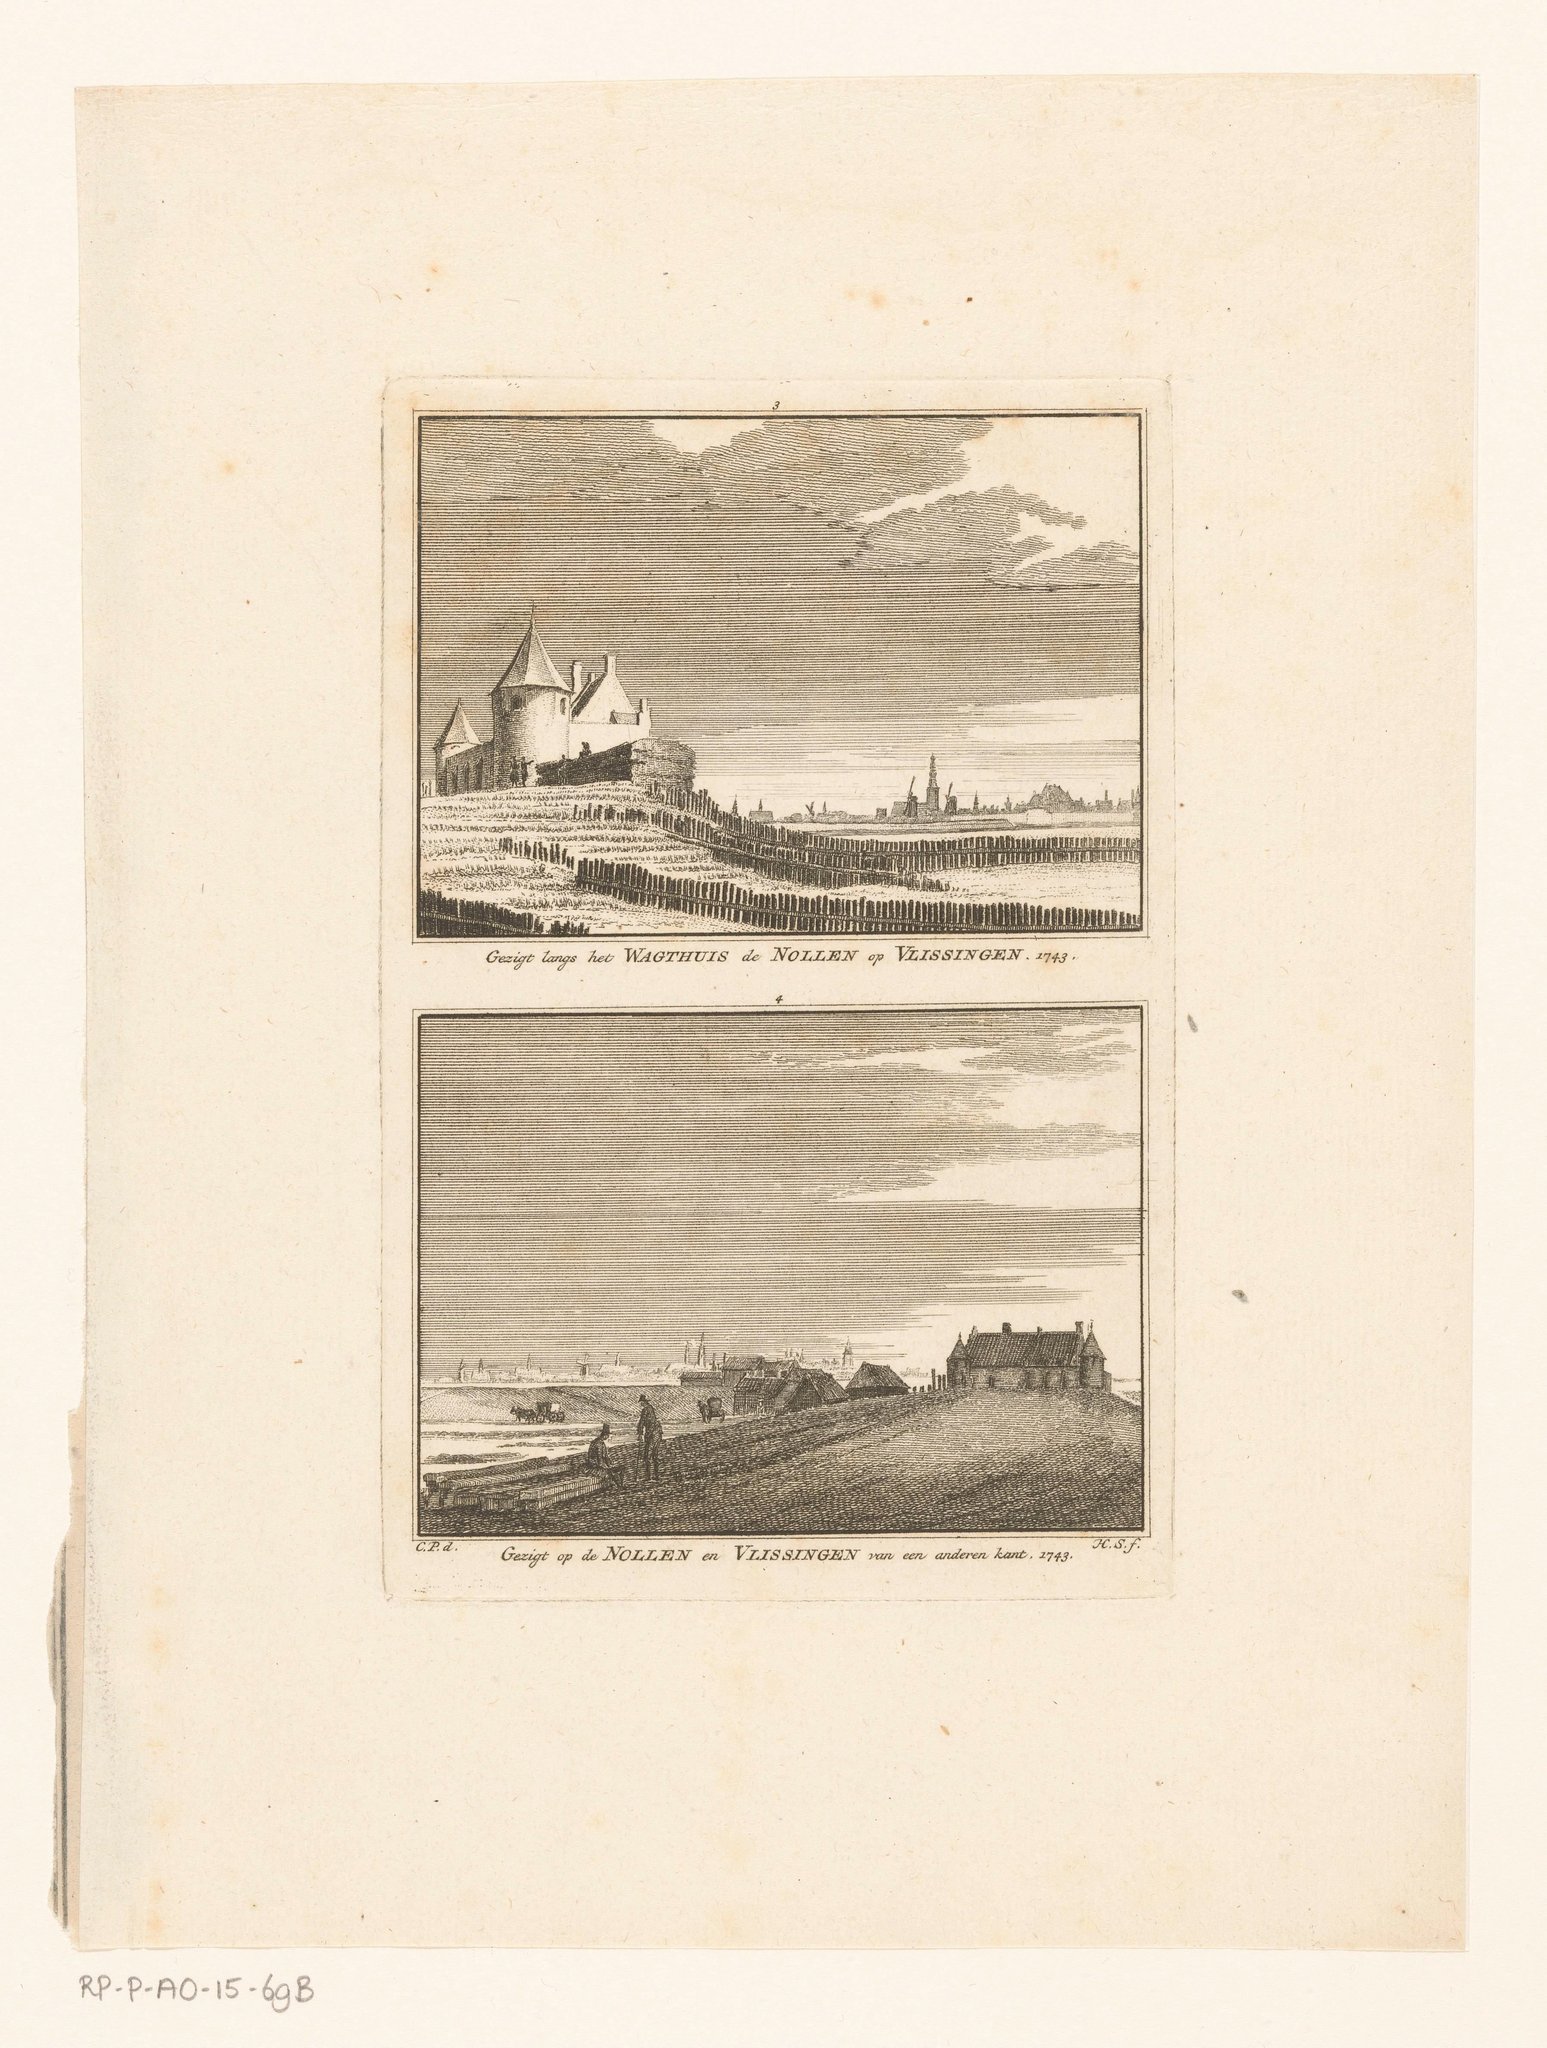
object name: print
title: Twee gezichten op het wachthuis De Nolle en op Vlissingen, 1743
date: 1754-1792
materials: paper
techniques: etching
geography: haarlem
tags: prospect of city, town panorama, silhouette of city, flushing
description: Prent ook gebruikt in: Het verheerlykt Nederland of kabinet van hedendaagsche gezigten van steden, dorpen (…). 9 delen. Amsterdam: Isaak Tirion en weduwe Isaak Tirion, 1745-1774, dl. 5 (1754), ill. 3-4. Of in: Nederlandsche tafereelen; of eene keurige verzameling van negen honderd fraaije gezigten van steden, dorpen, sloten, oudheden [….]. 9 delen. Amsterdam: Jan de Groot, 1792, dl. 5, ill. 3-4.